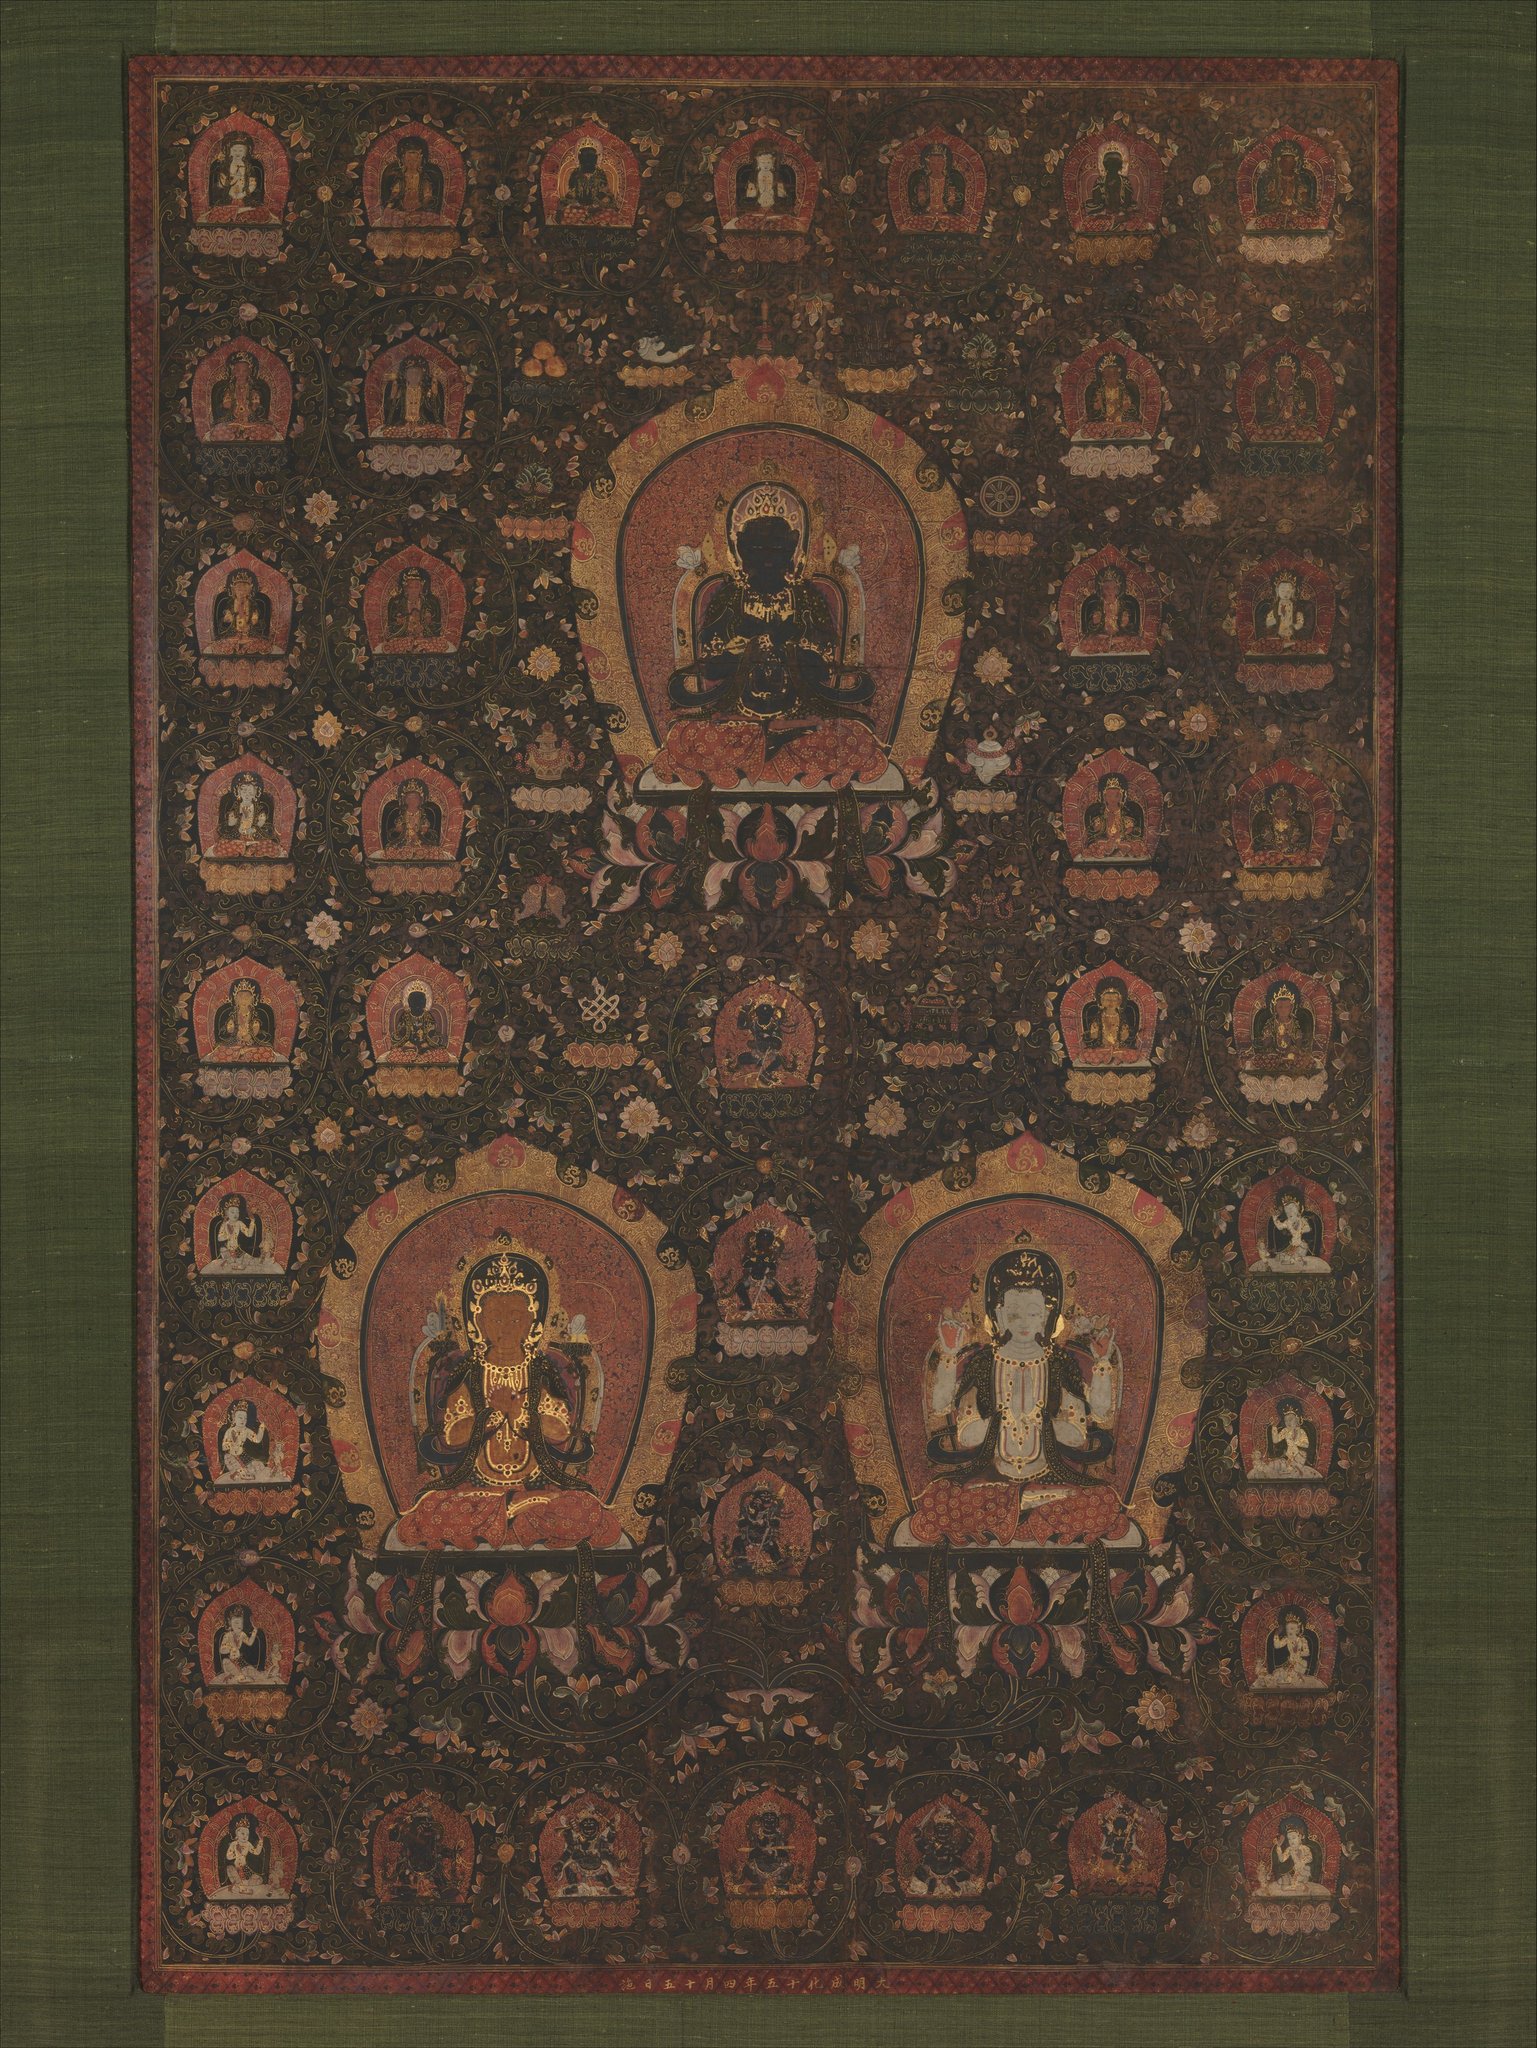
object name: thangka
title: Mandala of Vajradhara, Manjushri and Sadakshari -Lokeshvara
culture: chinese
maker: unidentified artist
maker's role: artist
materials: textile, cotton, gold, ink, watercolor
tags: buddhism,bodhisattvas,buddha,manjushri